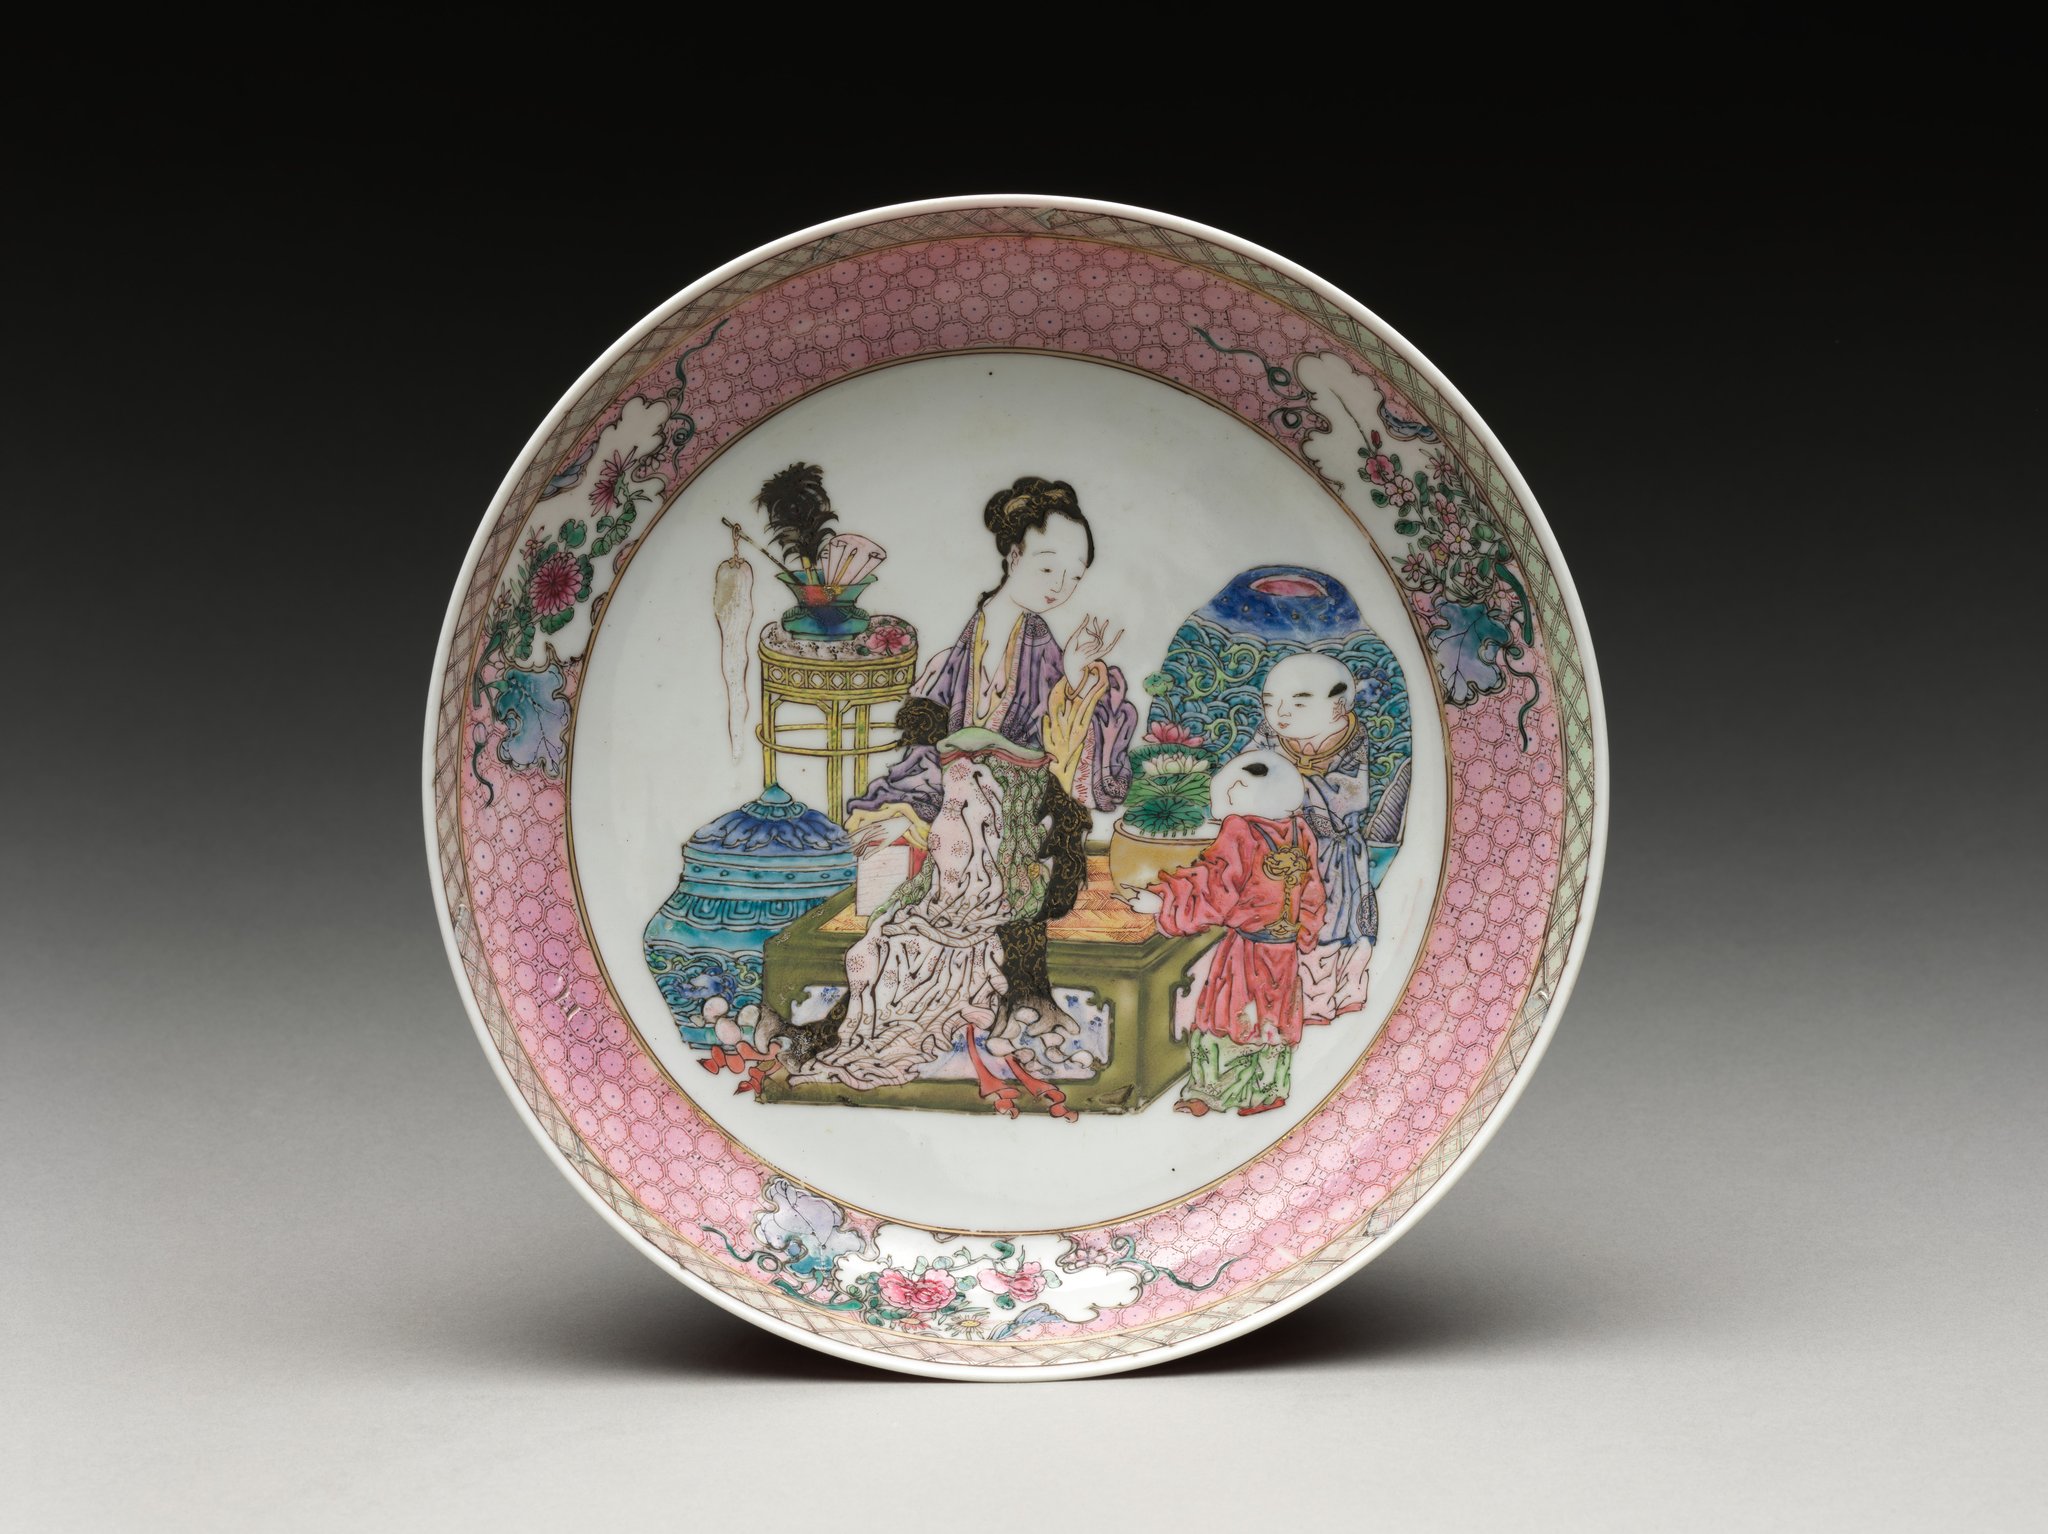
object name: dish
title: Dish with scene of a woman and children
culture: chinese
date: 1734-1766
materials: enamel, gold, porcelain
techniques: overglaze, painting, polychrome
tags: men,women